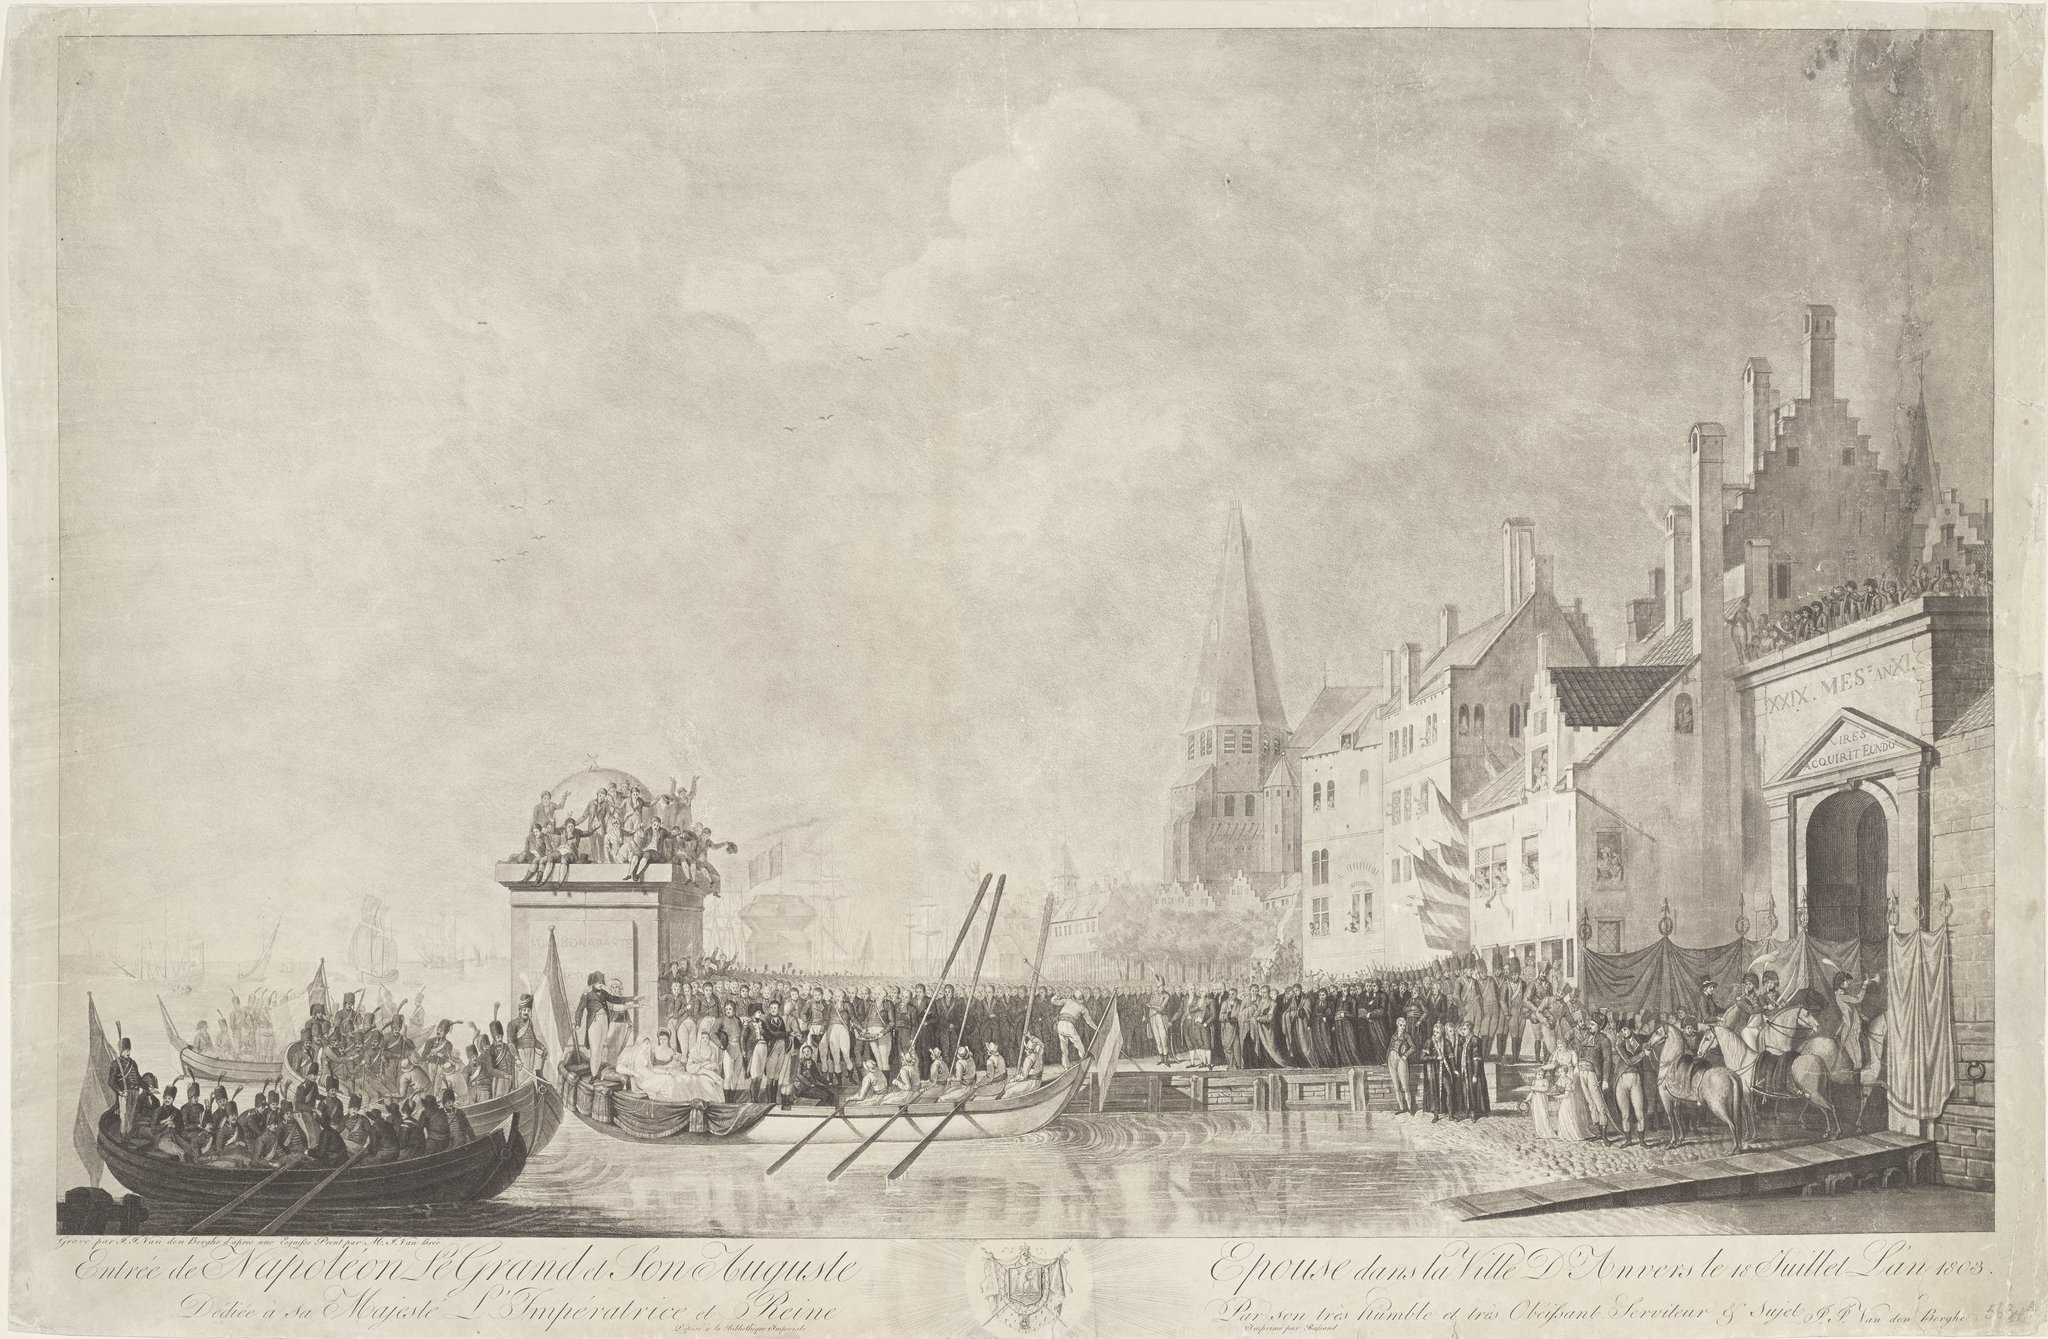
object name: print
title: Aankomst van Napoleon en Josephine te Antwerpen, 1803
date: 1803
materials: paper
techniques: aquatint, etching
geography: antwerp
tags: joséphine de beauharnais, napoleon i (emperor of the french), triumphal entry and public reception, pageant, 'entrée solennelle', 'joyeuse entrée', being welcomed ~ travelling, homage to a ruler, antwerp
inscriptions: collector's mark: Lugt 2228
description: Aankomst van keizer Napoleon Bonaparte met zijn echtgenote Josephine te Antwerpen, 18 juli 1803. De sloep met de keizer en keizerin legt aan bij de kade waar zij door het stadsbestuur met de sleutels van de stad opgewacht worden. Rechts wachtende paarden bij een stadspoort.